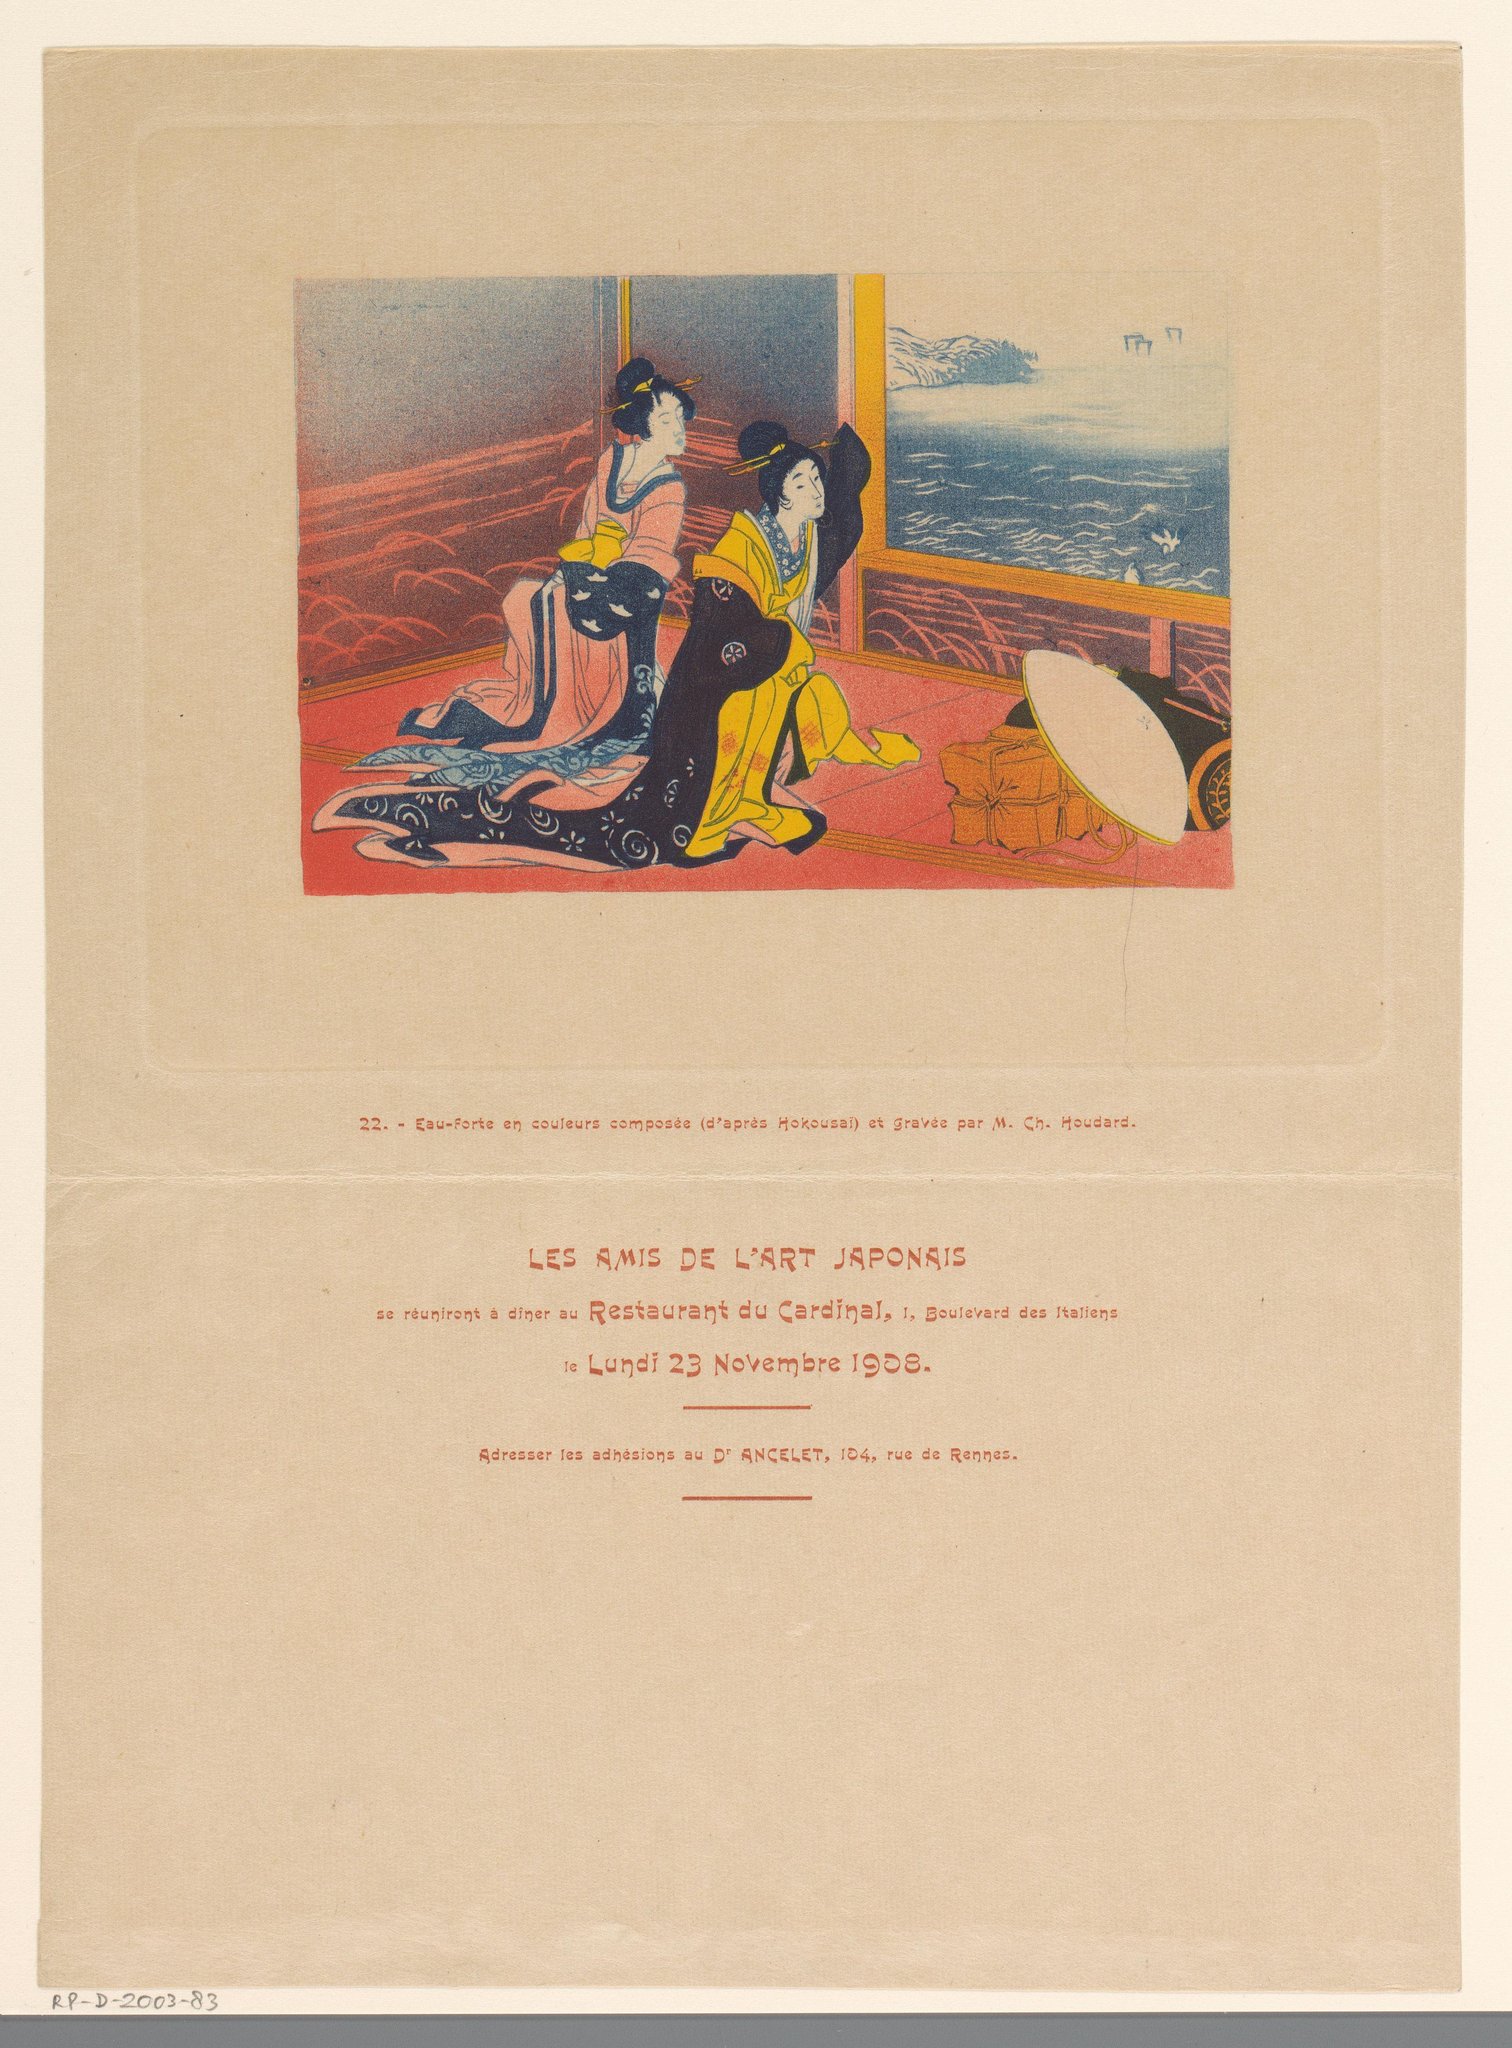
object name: print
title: Uitnodiging voor een diner van Les Amis de l'Art Japonais, 23 november 1908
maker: charles-louis houdard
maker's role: print maker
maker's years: 1855-1933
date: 1908-1911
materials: paper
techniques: color etching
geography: france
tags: courtesan, hetaera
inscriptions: collector's mark: Lugt 2228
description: Ets naar Japanse prent: twee vrouwen in een kamer. Uitnodiging voor een diner van Les Amis de l'Art Japonais, 23 november 1908.